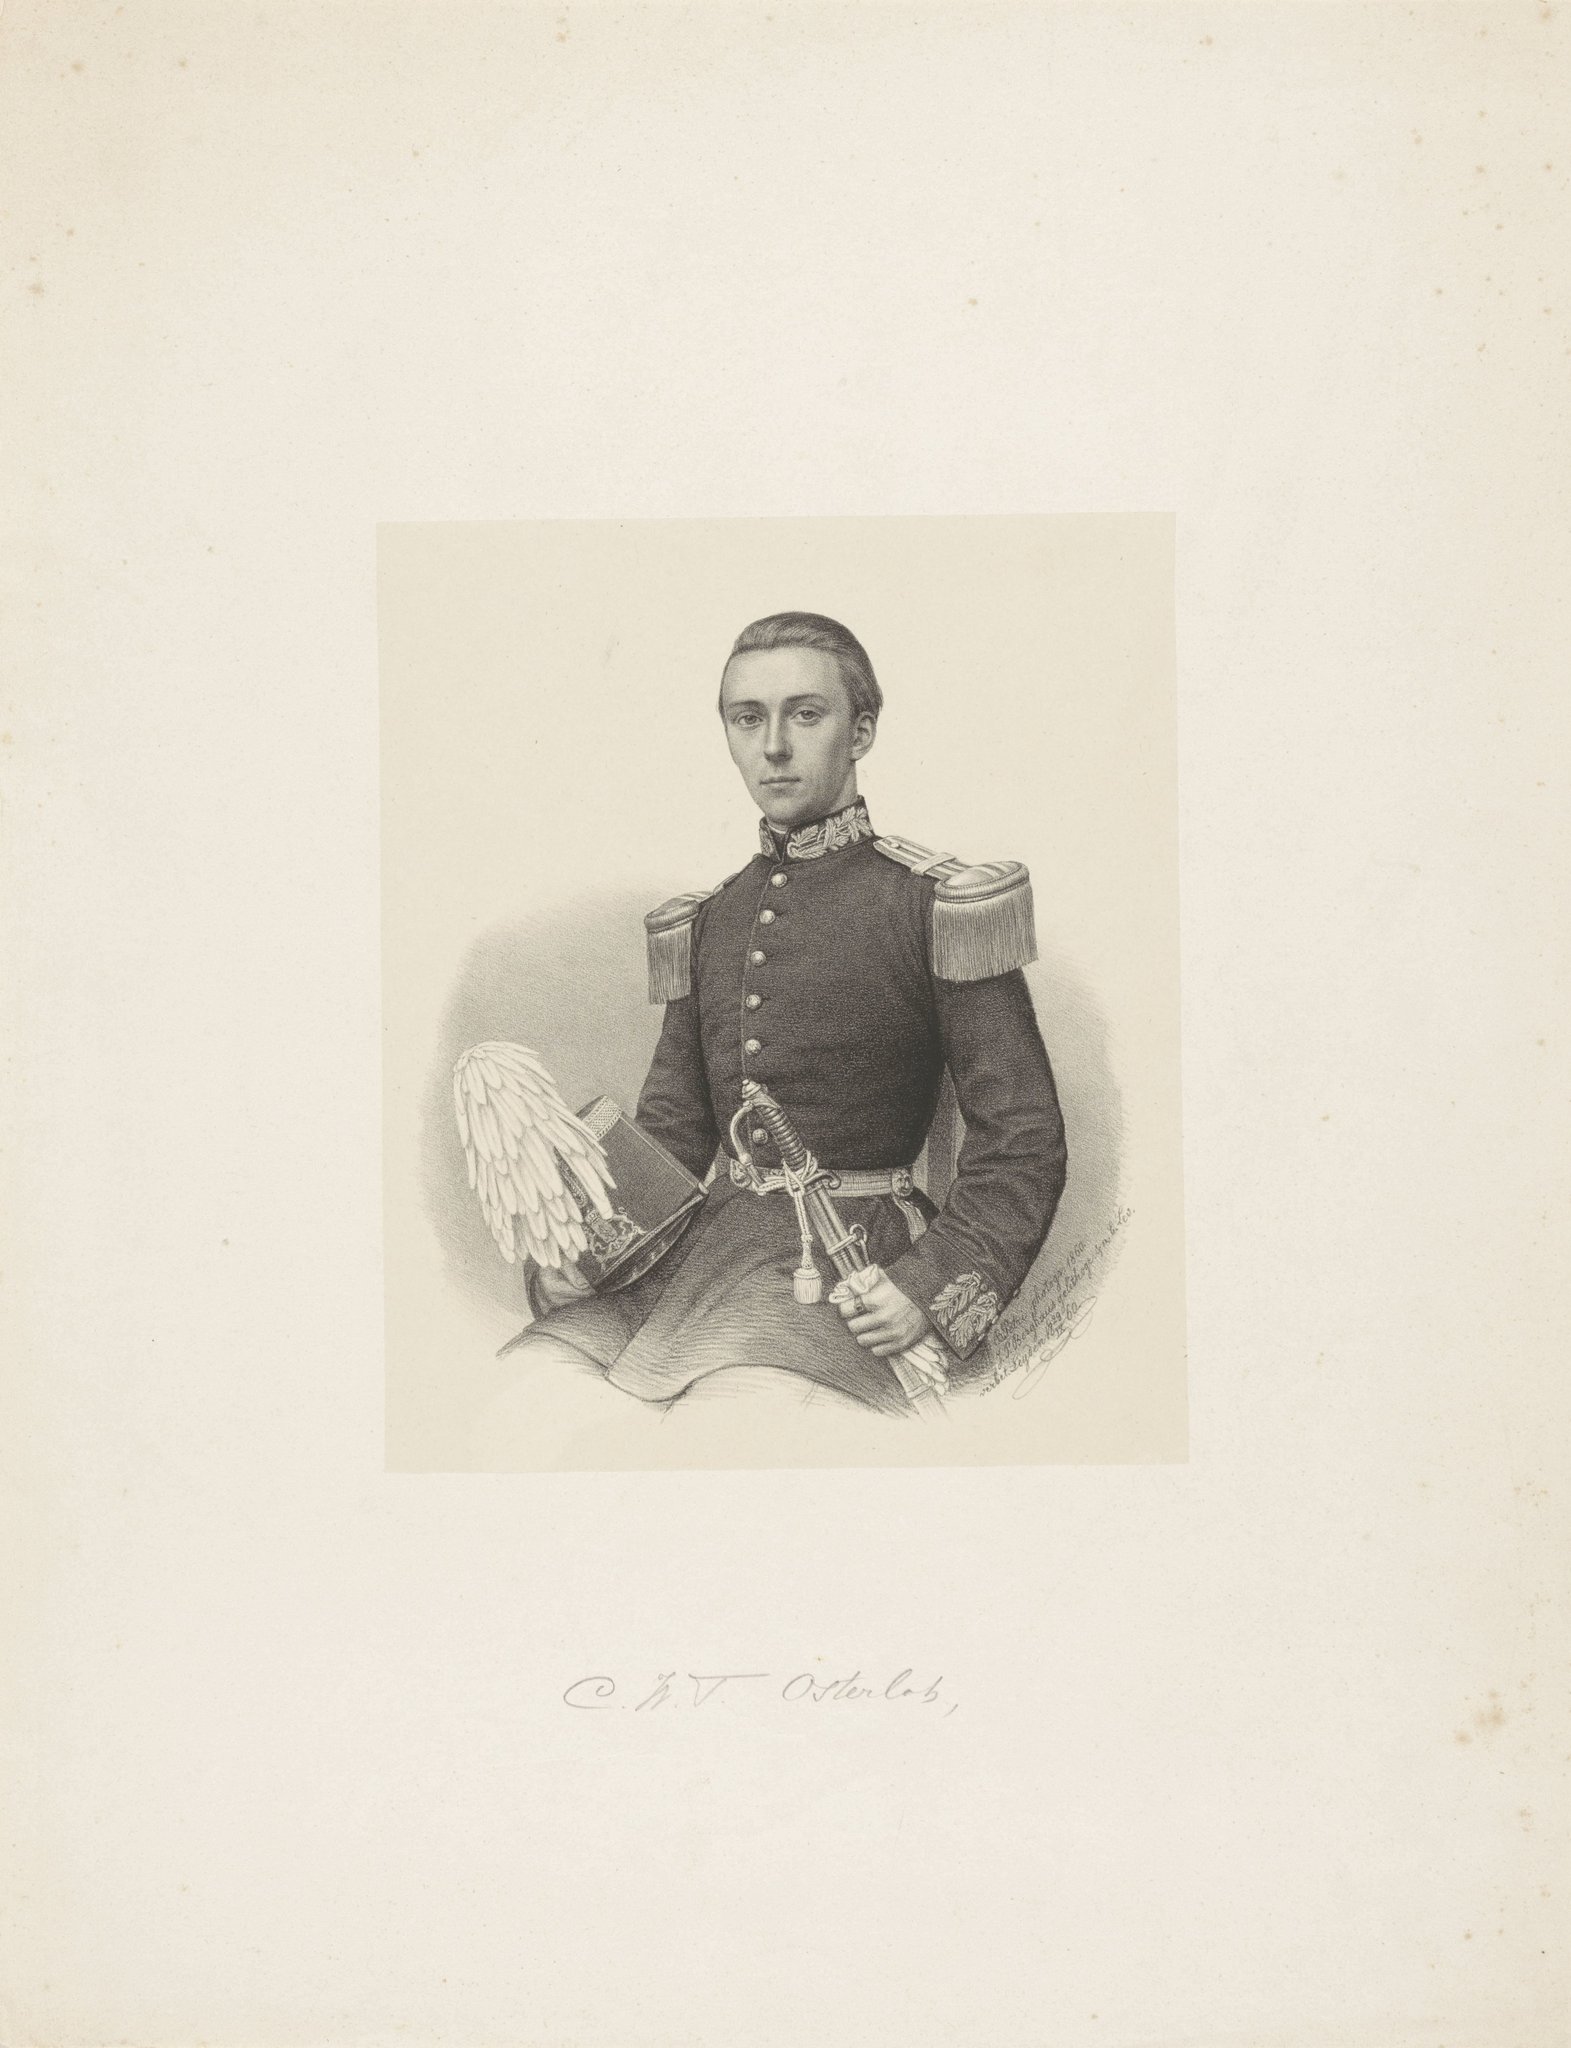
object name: print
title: Portret van een onbekende man, mogelijk C.W.T. Osterloh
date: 1860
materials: paper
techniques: lithograph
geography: leiden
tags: uniform cap (+ land forces), historical persons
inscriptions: inscription: ‘C. W. T. Osterloh.’, collector's mark: Lugt 2228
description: De geportretteerde draagt een militair uniform. Zijn hoed met pluim houdt hij in zijn rechterhand, zijn sabel en handschoenen in zijn linkerhand.